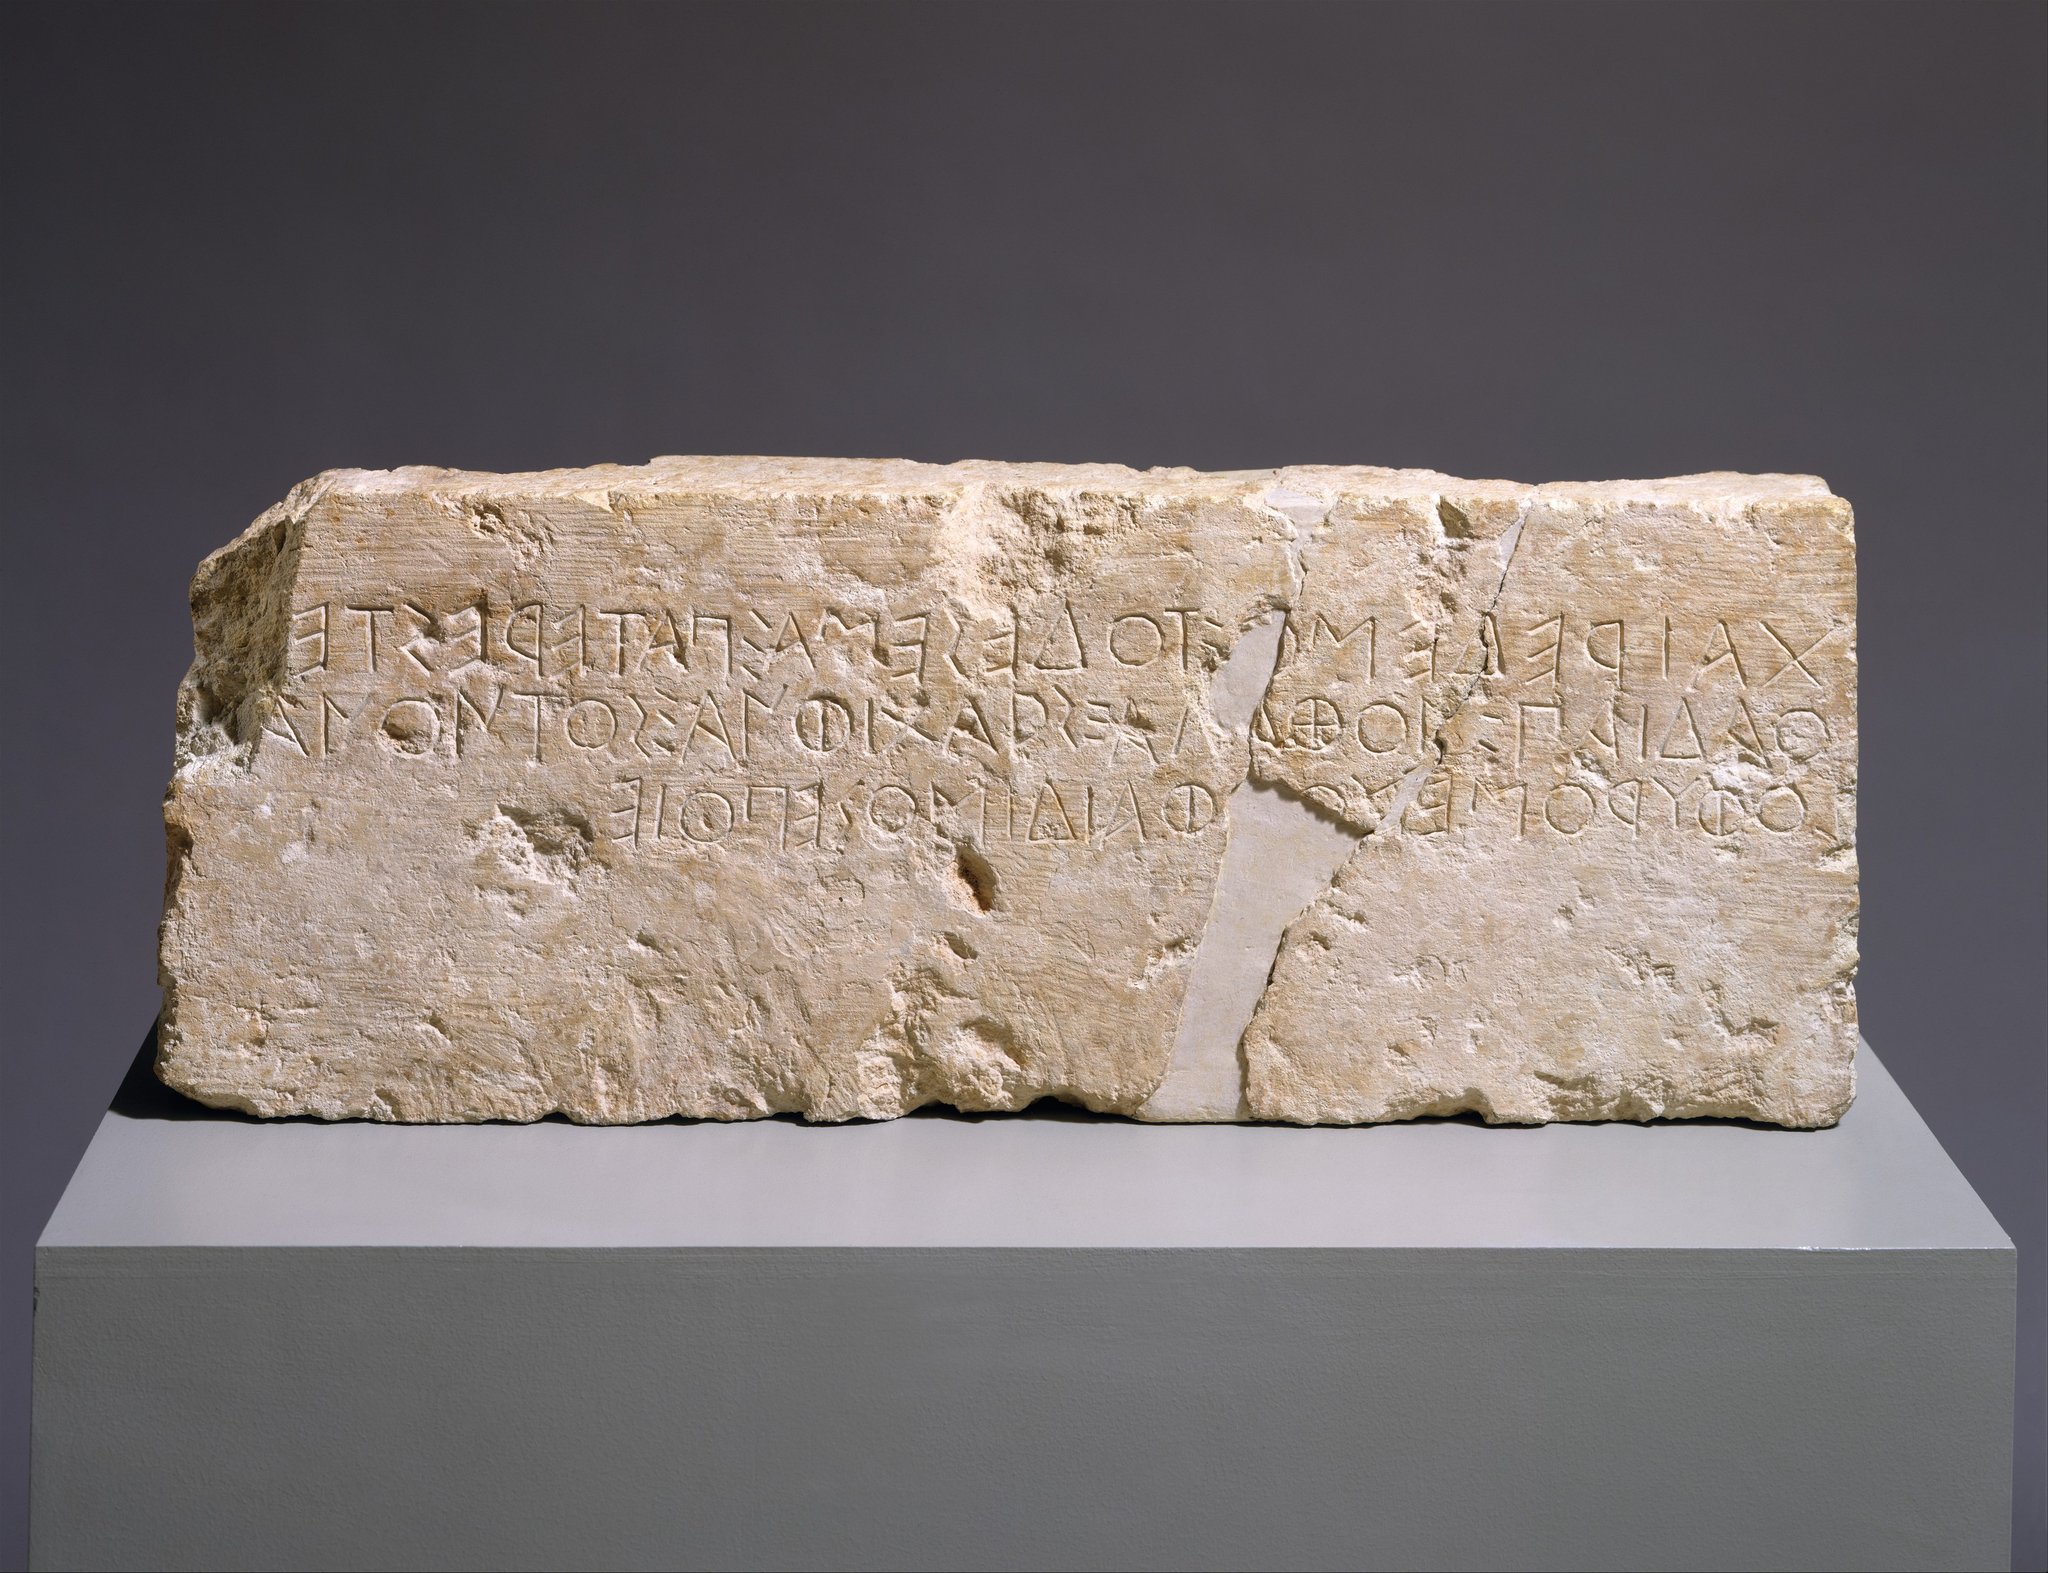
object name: stele, inscribed base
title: Front of a limestone block from the stepped base of a funerary monument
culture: greek, attic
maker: phaidimos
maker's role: artist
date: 567-535 BCE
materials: limestone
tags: poetry